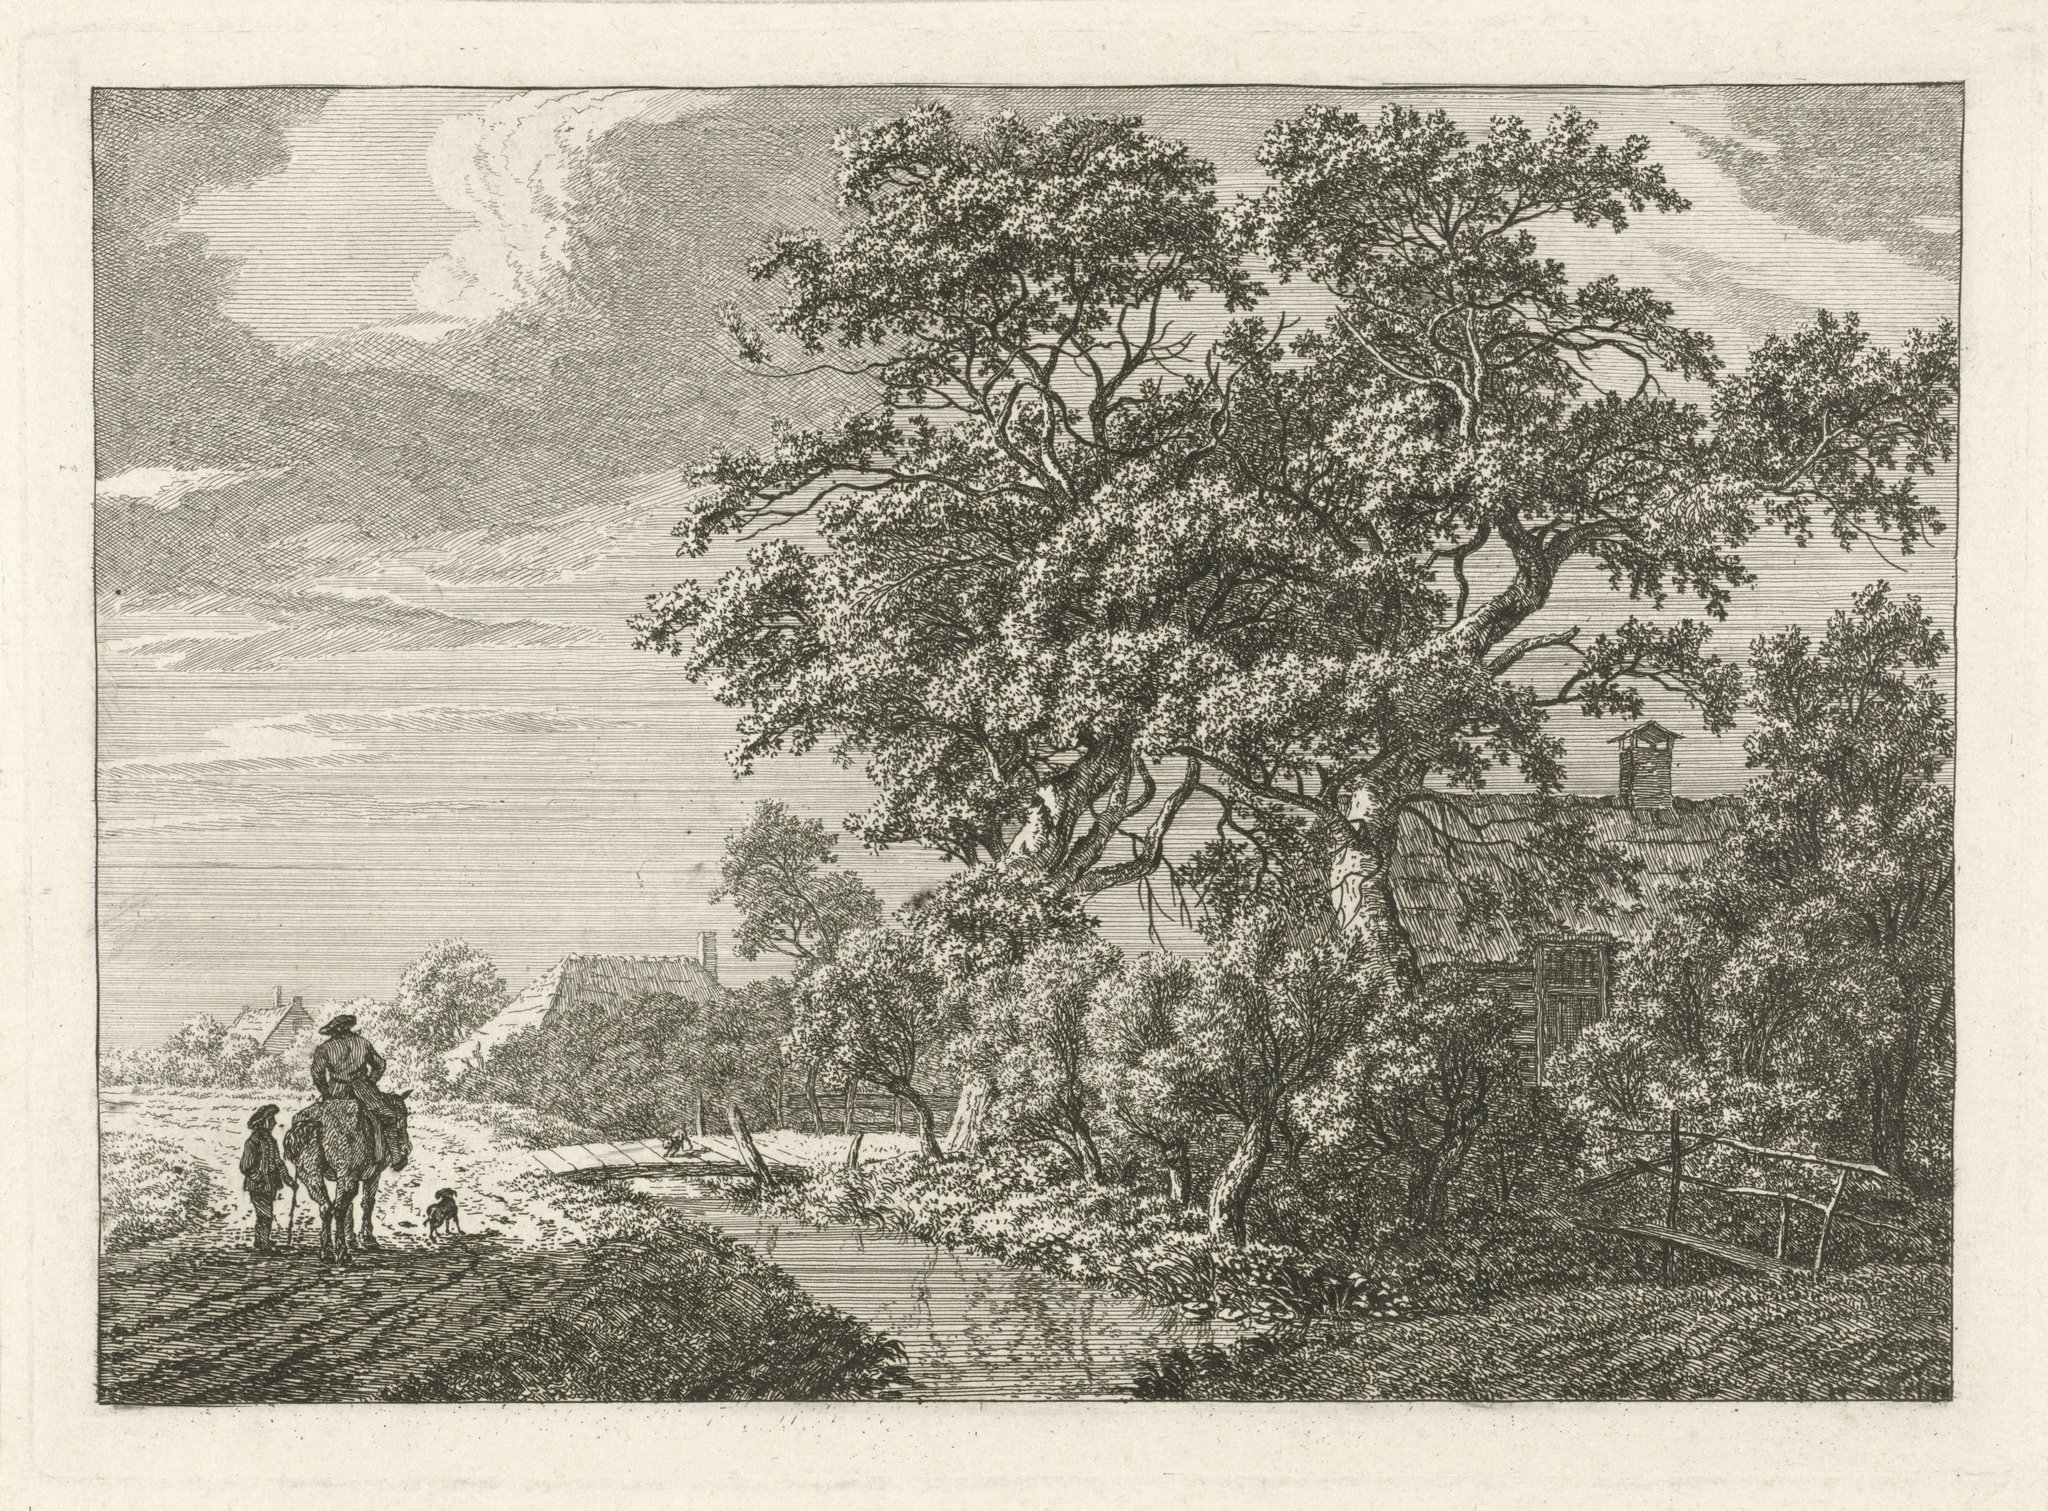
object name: print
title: Landschap met een sloot en boerderijen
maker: franciscus andreas milatz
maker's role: draughtsman, painter, print maker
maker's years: 1764-1808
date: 1784-1808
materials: paper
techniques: etching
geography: haarlem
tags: riding a horse, ass, or mule; rider, horseman, small canal, ditch, farm or solitary house in landscape, dog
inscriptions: collector's mark: Lugt 2228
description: Op een weg langs een sloot een ruiter met een staande man in gesprek en een hond. Links boerderijen achter de bomen. Op de houten brug een hond.